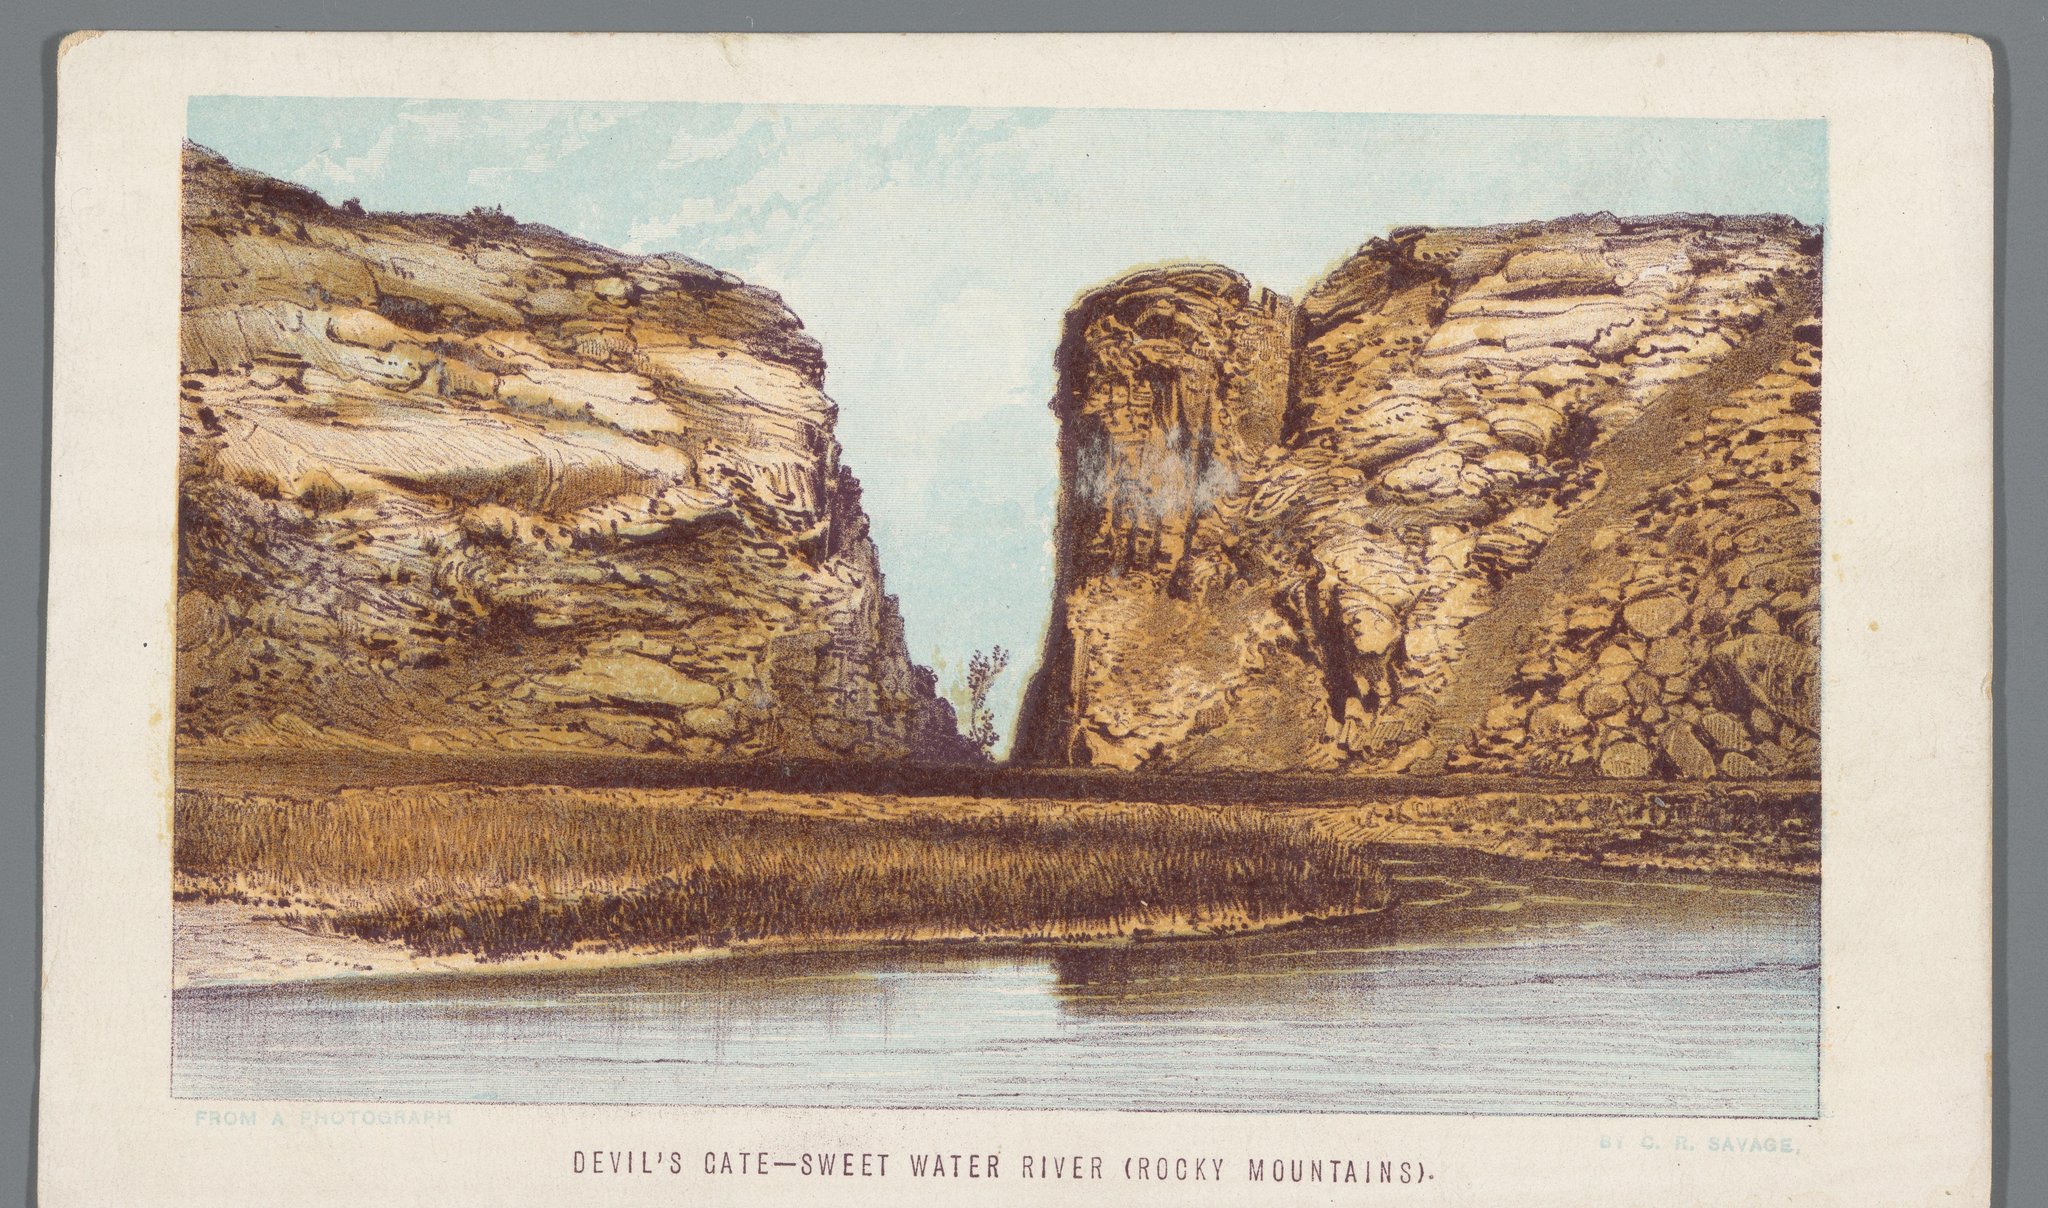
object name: print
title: Devil's Gate - Sweet Water River (Rocky Mountains)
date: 1870-1875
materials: paper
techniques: lithograph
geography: edinburgh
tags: river, rock-formations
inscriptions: inscription: ‘From a photograph by C.R. Savage.’